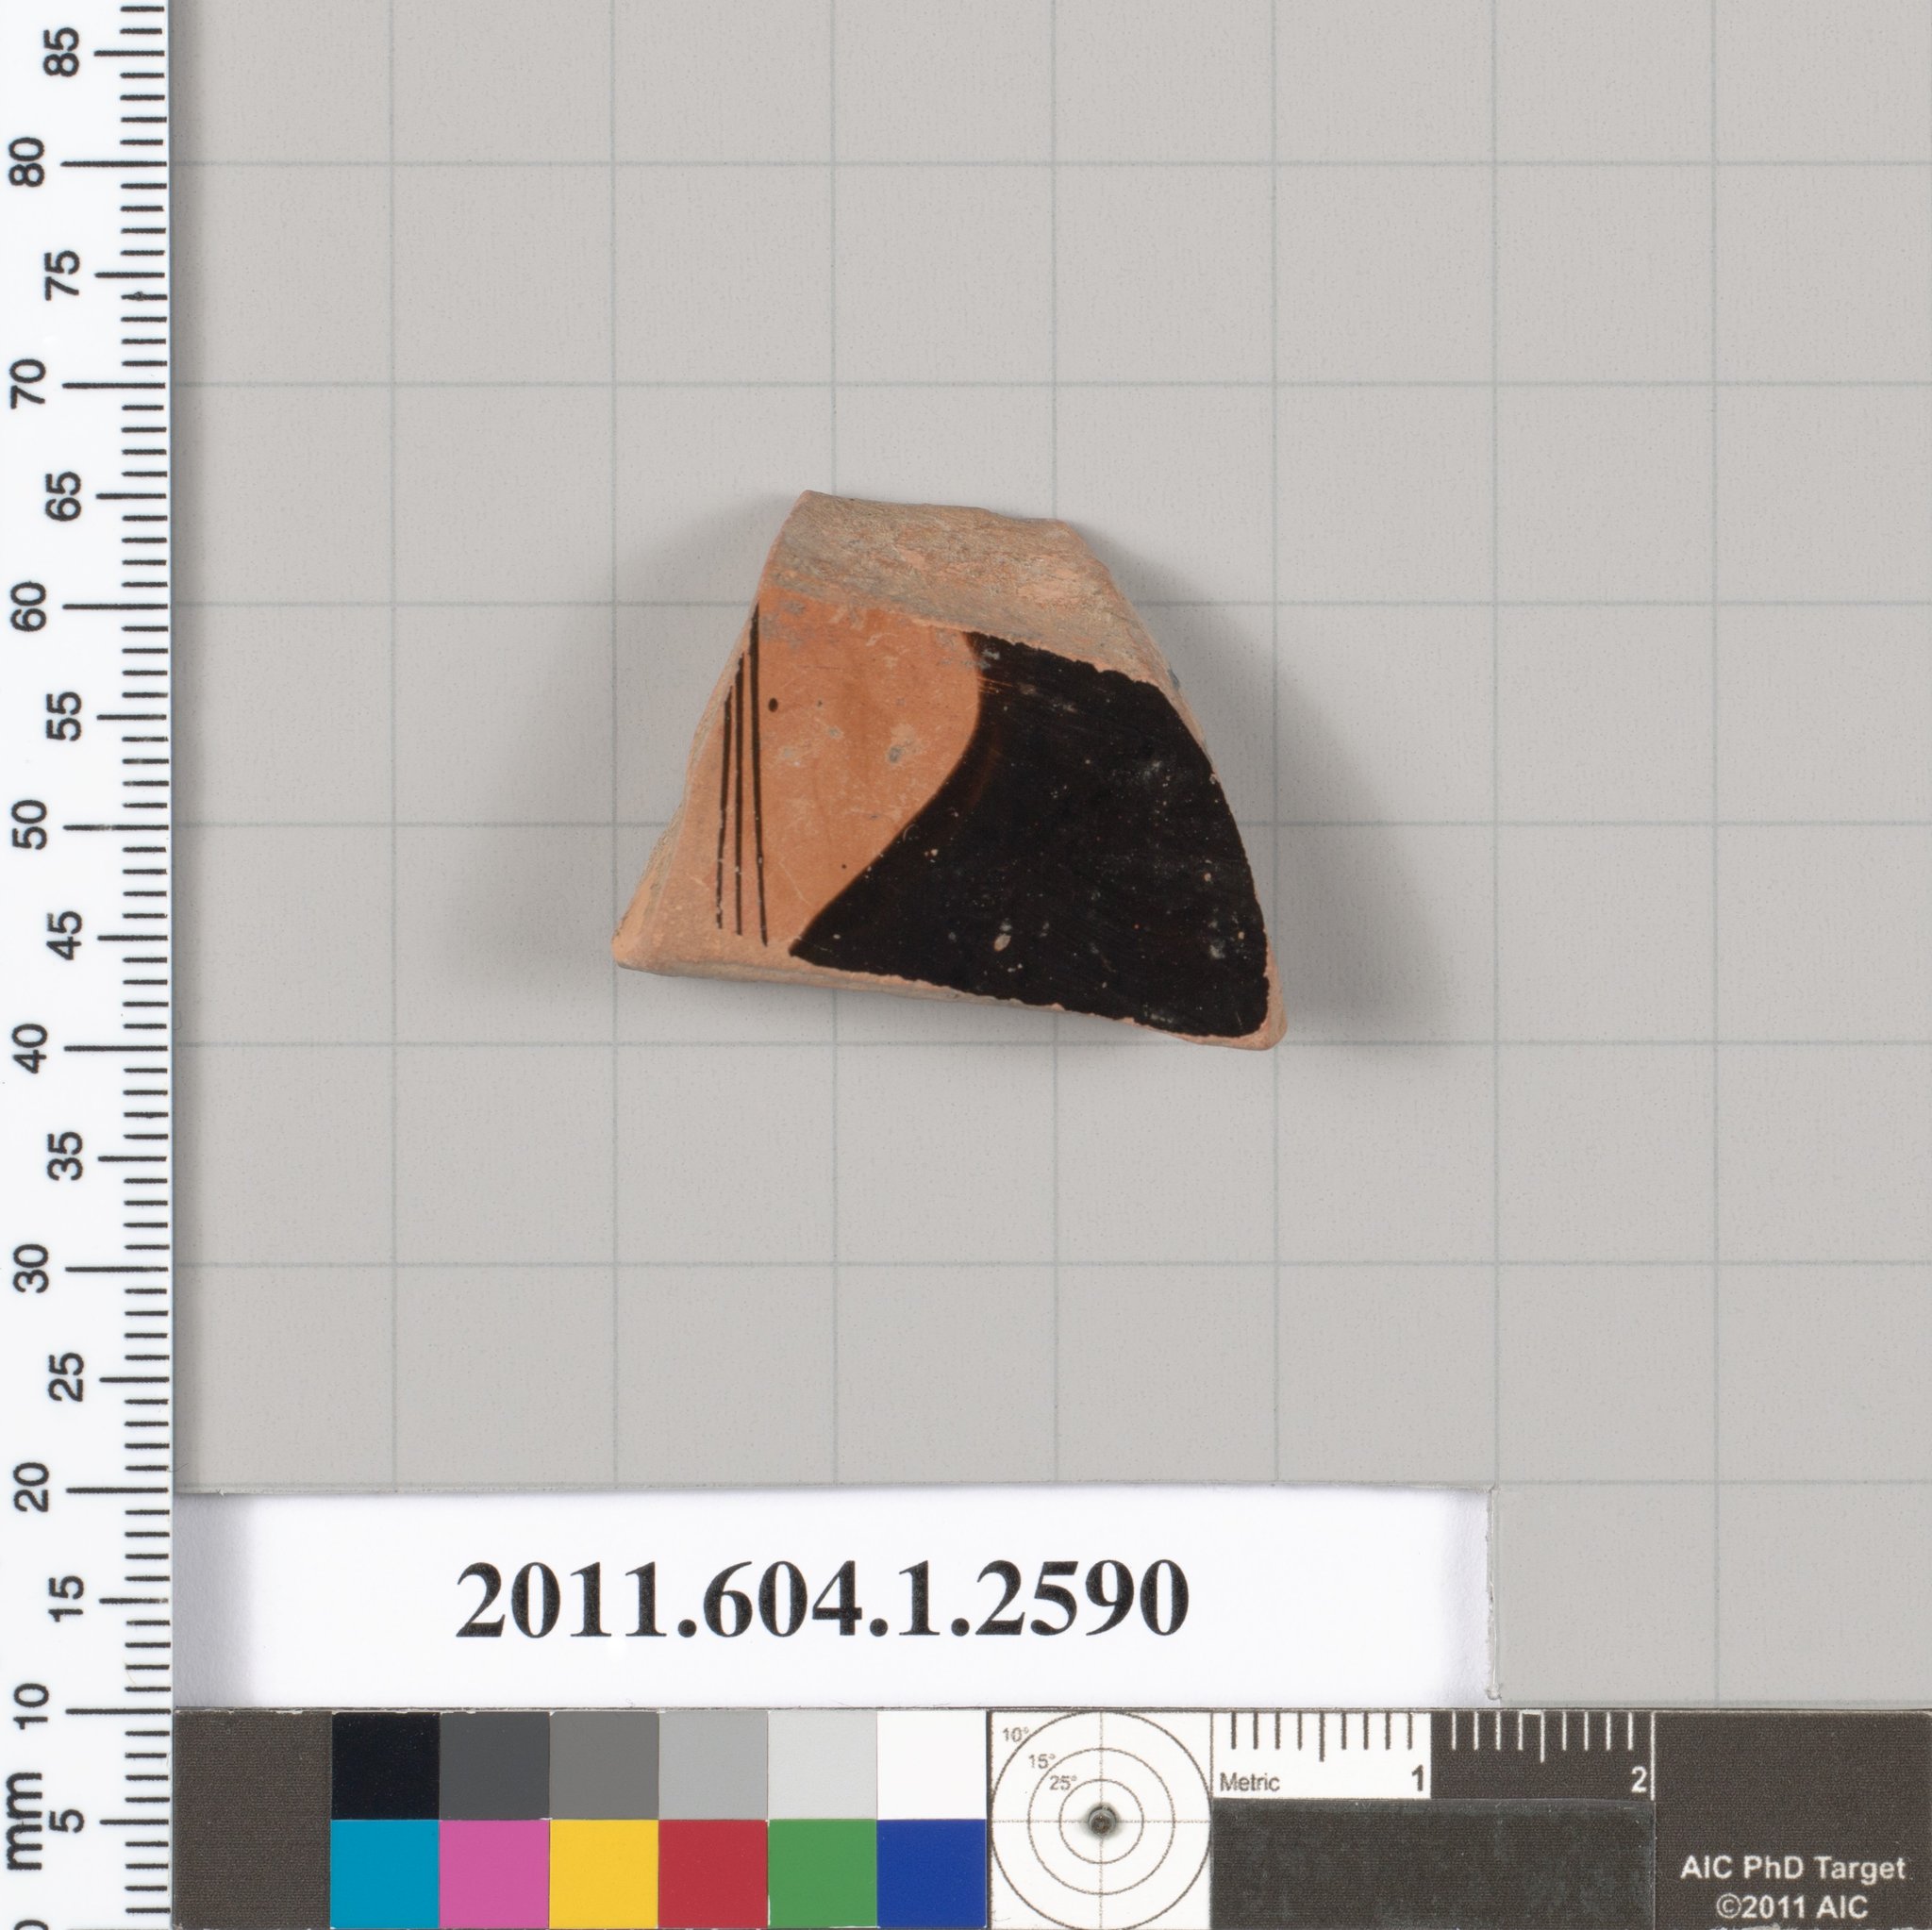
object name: kylix fragment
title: Terracotta fragment of a kylix (drinking cup)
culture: greek, attic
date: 475-451 BCE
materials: terracotta